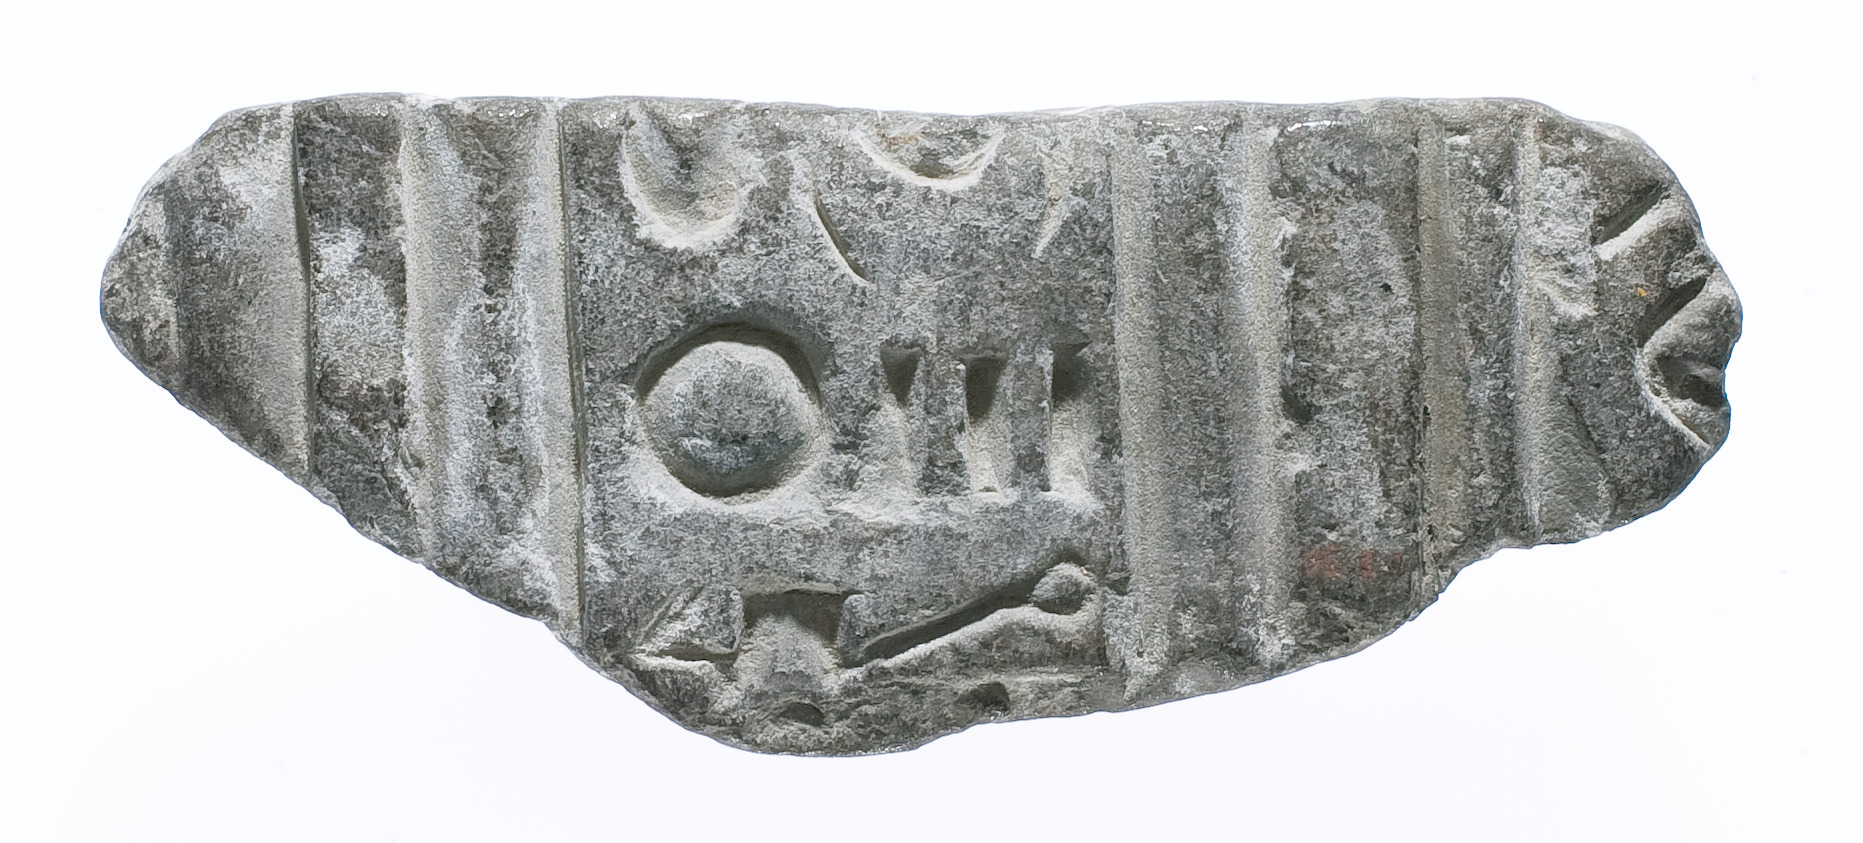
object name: inscribed fragment, akhenaten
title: Fragment of cartouche of Akhenaten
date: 1353-1336 BCE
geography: egypt